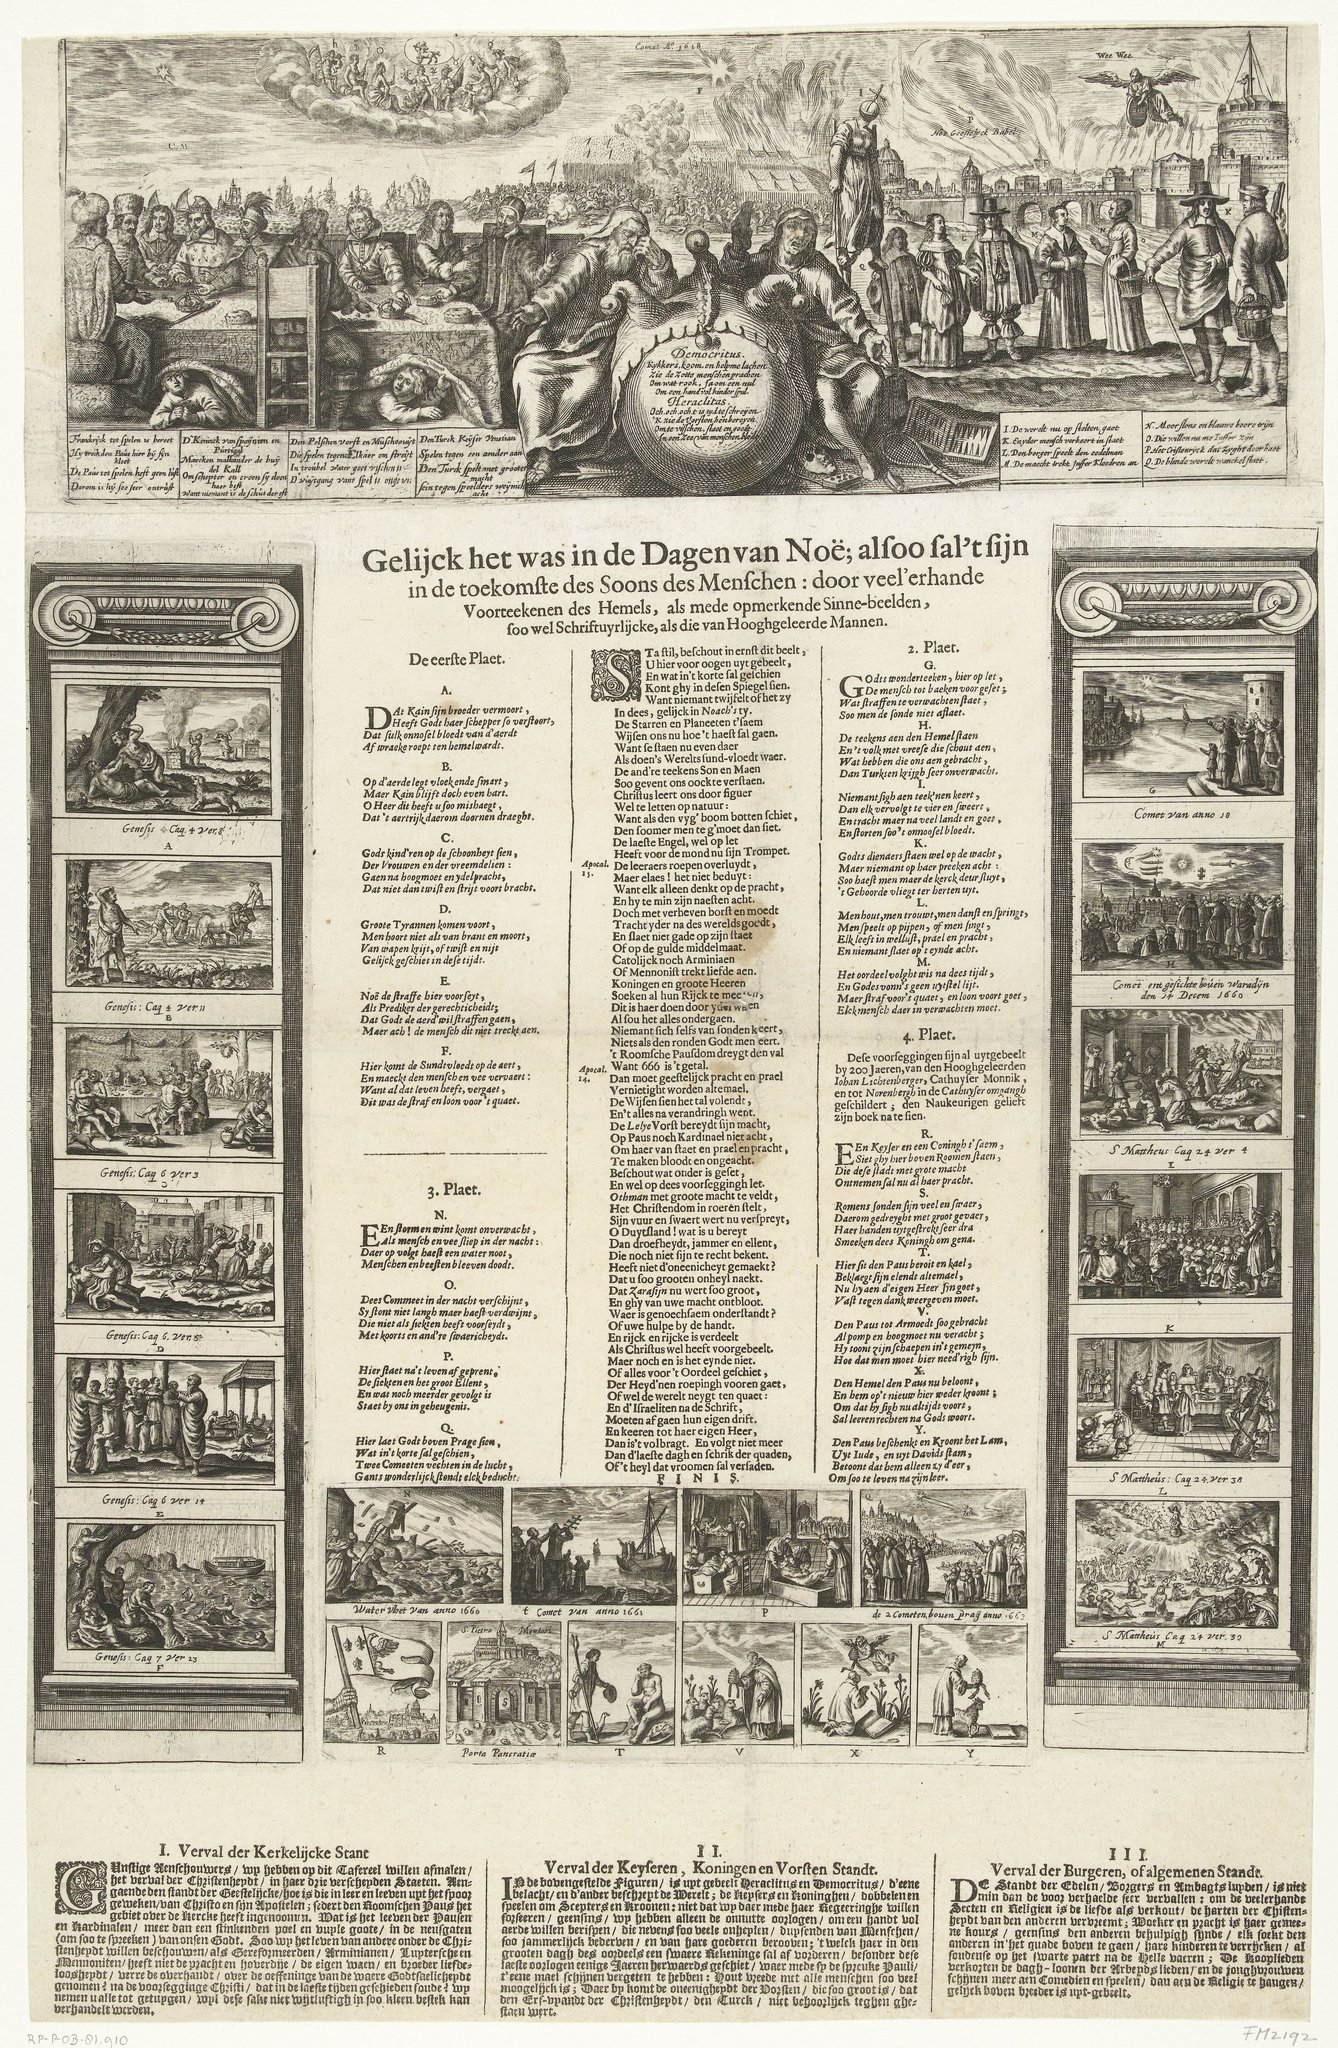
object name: print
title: Prognosticatie van het einde van de wereld, ca.1663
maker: crispijn van de passe (ii)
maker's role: draughtsman, print maker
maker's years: 1594-1670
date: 1644-1645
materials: paper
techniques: engraving, letterpress printing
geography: amsterdam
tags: story of noah, comet, dice, heraclitus, the weeping philosopher, and democritus, the laughing philosopher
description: Allegorisch blad met de prognosticatie van het einde van de wereld, ca. 1663. Bovenaan een voorstelling waarin links de wereldlijke en geestelijke vorsten dobbelen over het lot van de burger en boer. Rechts het burgerlijk leven en de wereld op stelten. Op de achtergrond oorlogen ter land en ter zee, in de hemel de acht goden van de planeten en de komeet van 1628. Centraal de filosofen Democritus en Heraclites bij een wereldbol onder een narrenkap. Hieronder een blad vastgeplakt met aan weerszijden in pilasters en onderaan kleine voorstellingen gemerkt A-Y uit het verhaal van Noach en de Zondvloed en hemelverschijnselen uit de afgelopen jaren 1660-1663; in het midden de verklarende teksten.